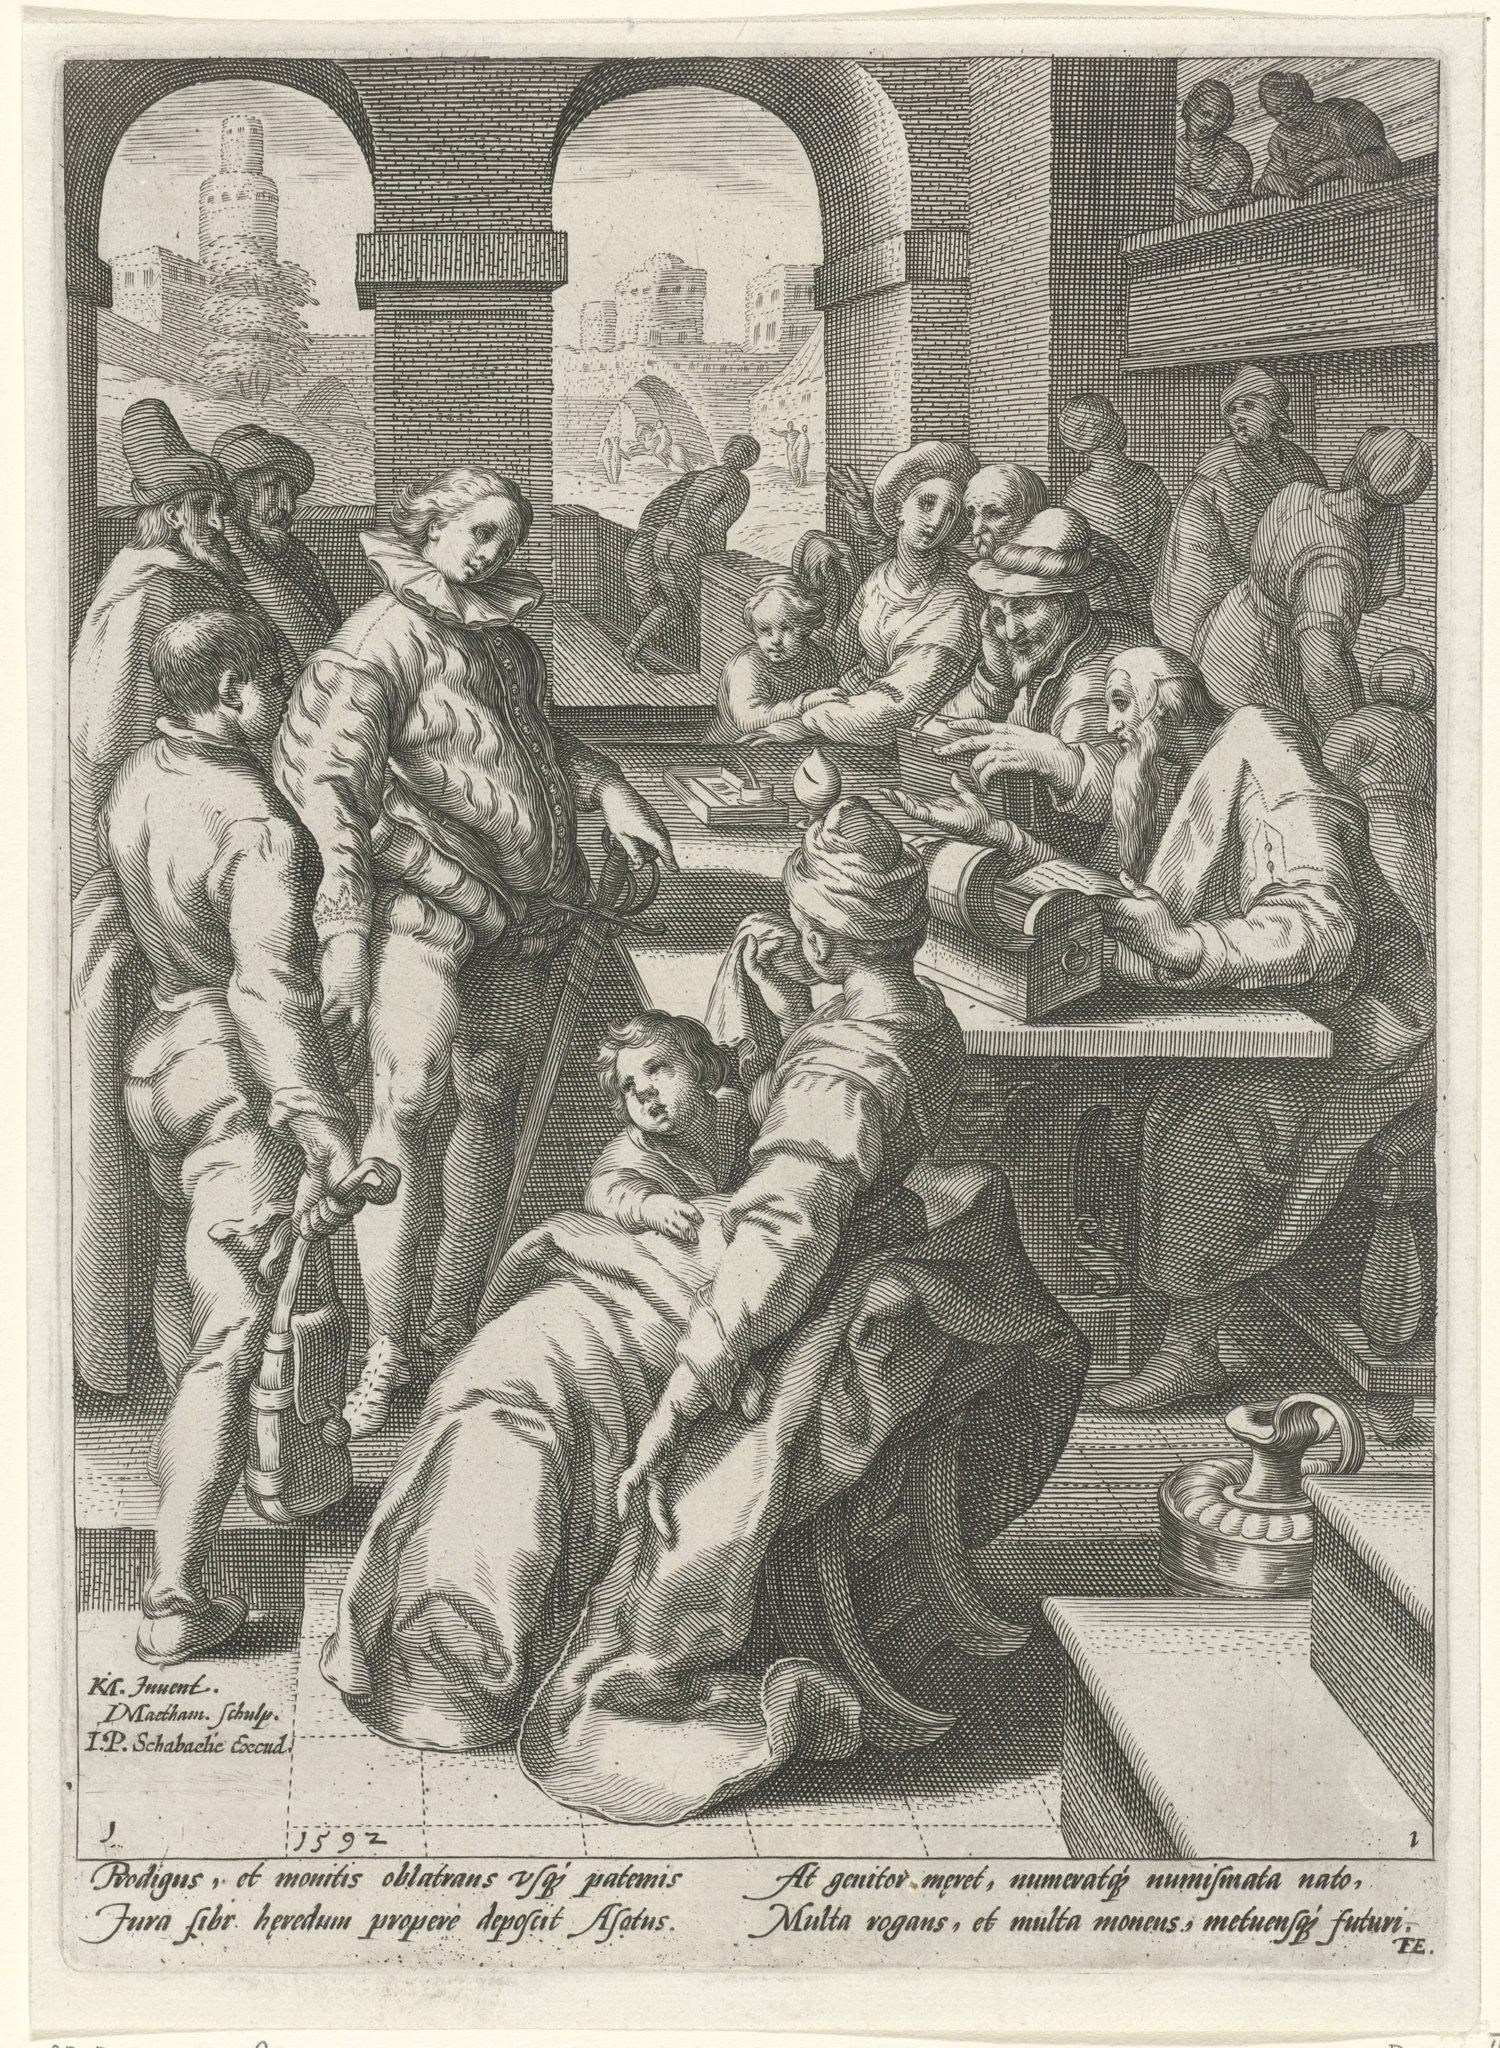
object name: print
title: Parabel van de verloren zoon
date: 1592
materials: paper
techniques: engraving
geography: amsterdam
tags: bag (+ men's clothes), the parable of the prodigal son (luke 15:11-32), money-chest, treasure-chest, money-box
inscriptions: date: ‘1592’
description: Een jonge man staand voor een tafel waarachter heren met een (geld)kistje. Naast hem een knecht met zijn mantel en reistas. Op de achtergrond rijdt hij op een paard door de stadspoort.